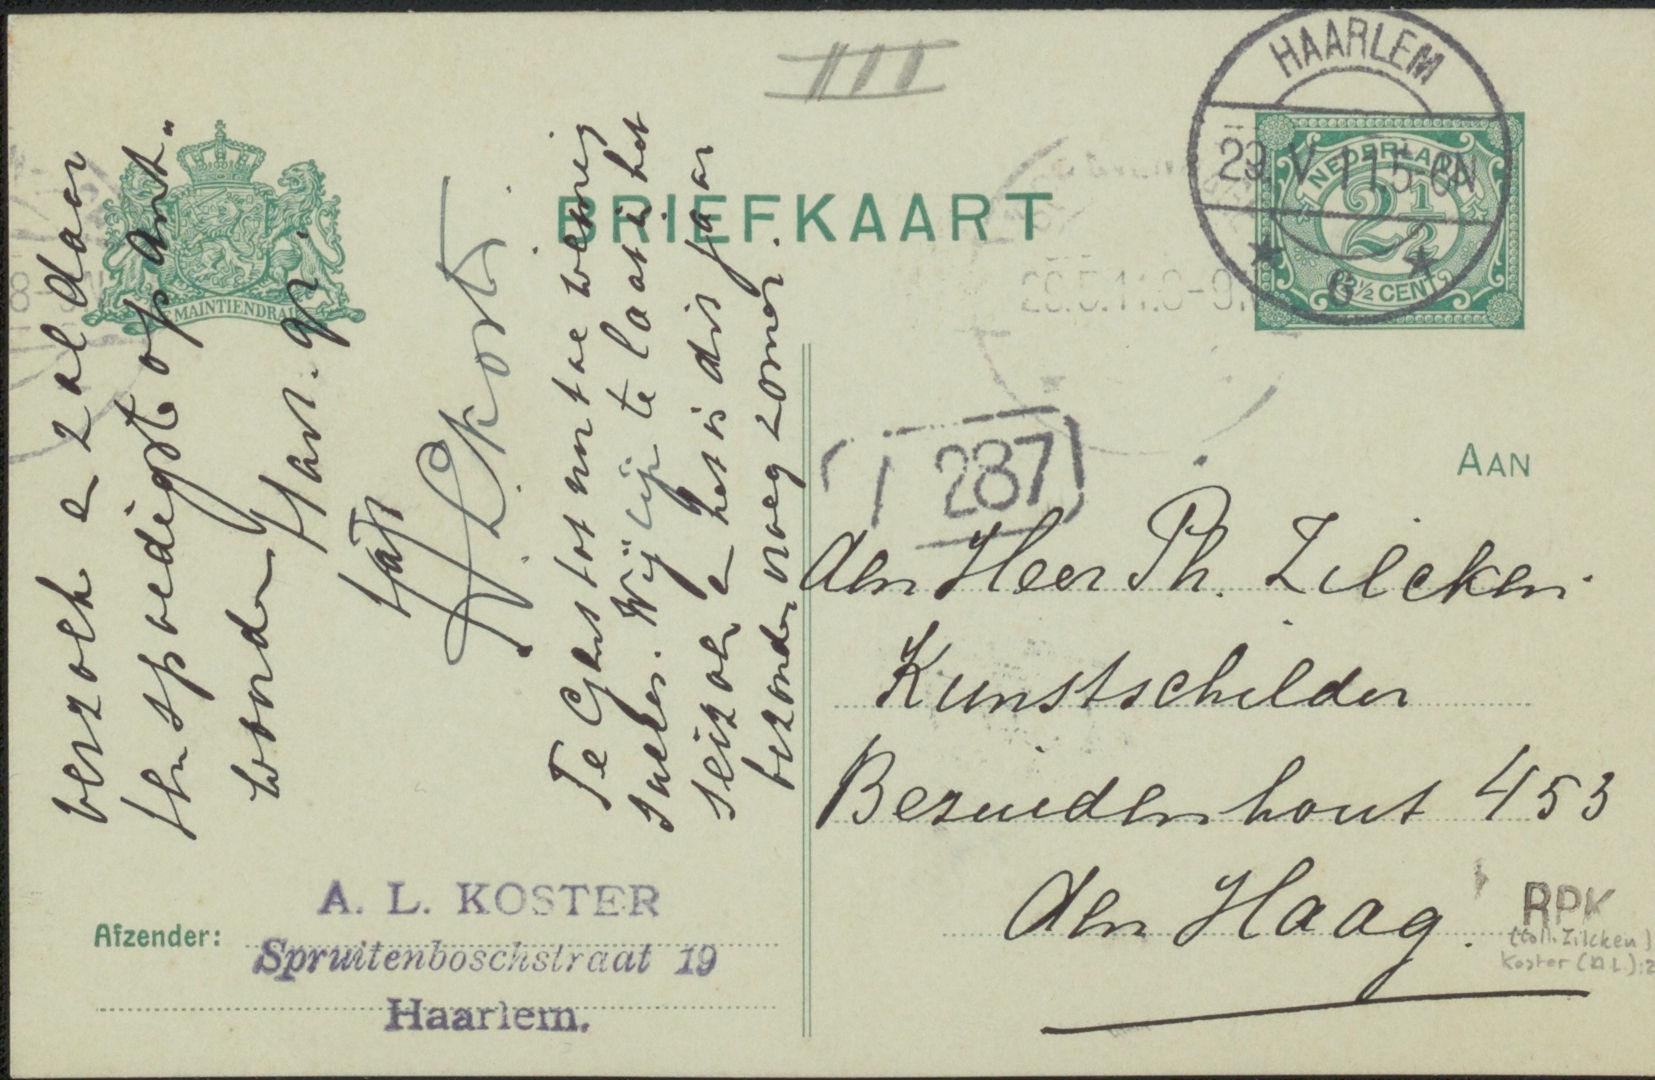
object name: postcard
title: Briefkaart aan Philip Zilcken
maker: anton l. koster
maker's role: draughtsman, painter, print maker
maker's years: 1859-1937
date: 1911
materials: cardboard, ink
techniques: pen, writing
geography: haarlem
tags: the hague, willem hendrik bik, amsterdam, print maker, carl august breitenstein, publisher, painter, philip zilcken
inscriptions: collector's mark: ‘RPK’, address: ‘A. L. KOSTER/ Spruitenboschstraat 19/ Haarlem.’